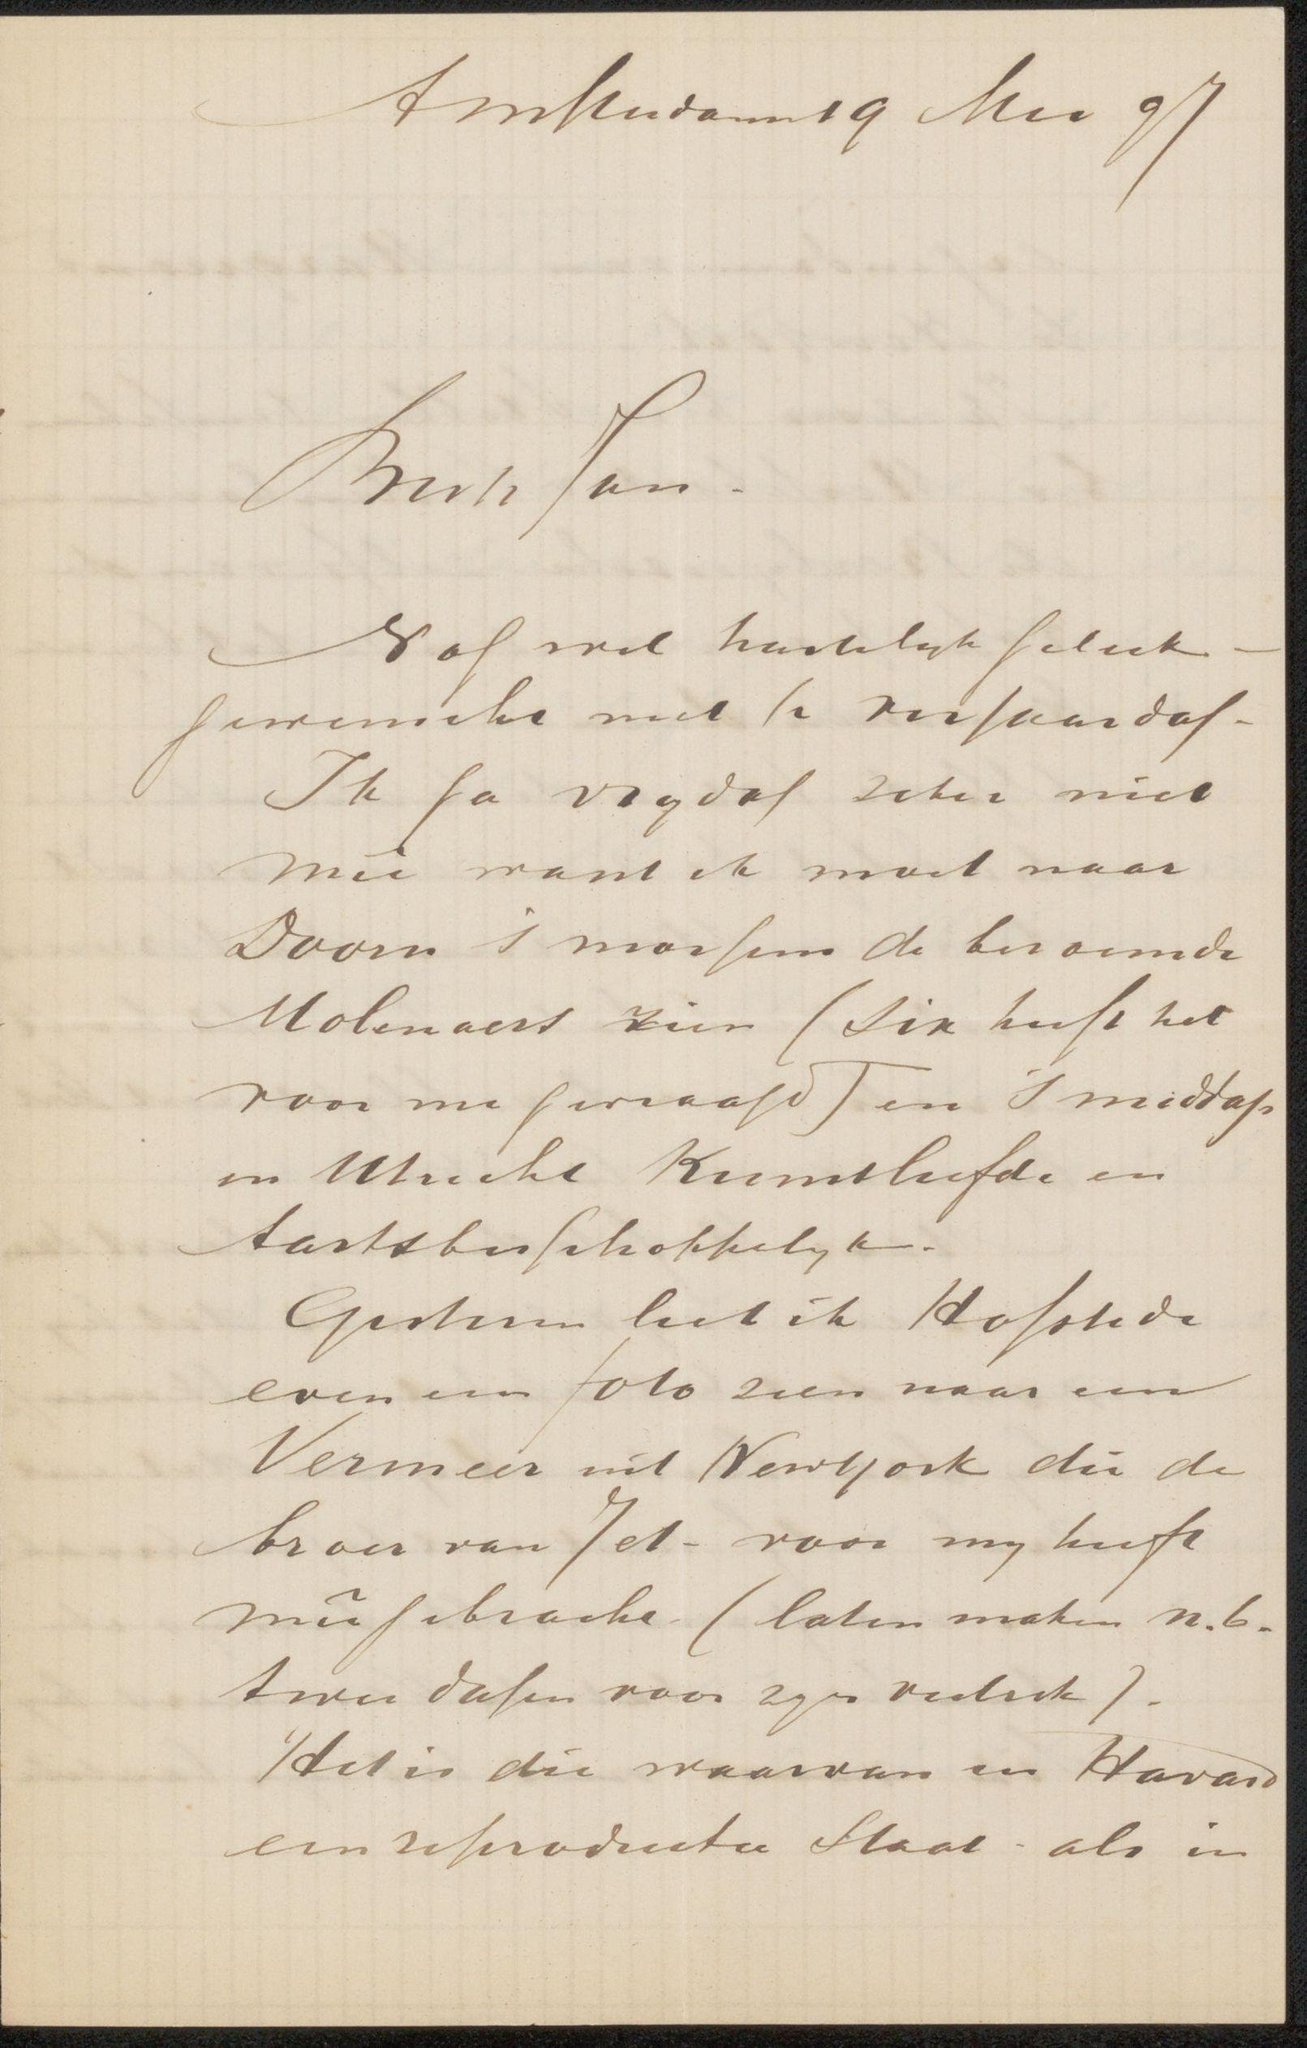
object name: letter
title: Brief aan Jan Veth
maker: cornelis gerardus t hooft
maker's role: draughtsman, painter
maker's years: 1866-1936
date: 1897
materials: ink, paper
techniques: pen, writing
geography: amsterdam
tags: delft, johannes vermeer, dordrecht, painter, print maker, draughtsman, designer, jan veth, leiden, rembrandt van rijn, amsterdam, jonkheer jan six, the hague, cornelis hofstede de groot, the graphic arts, new york (city)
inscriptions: collector's mark: ‘RPK’